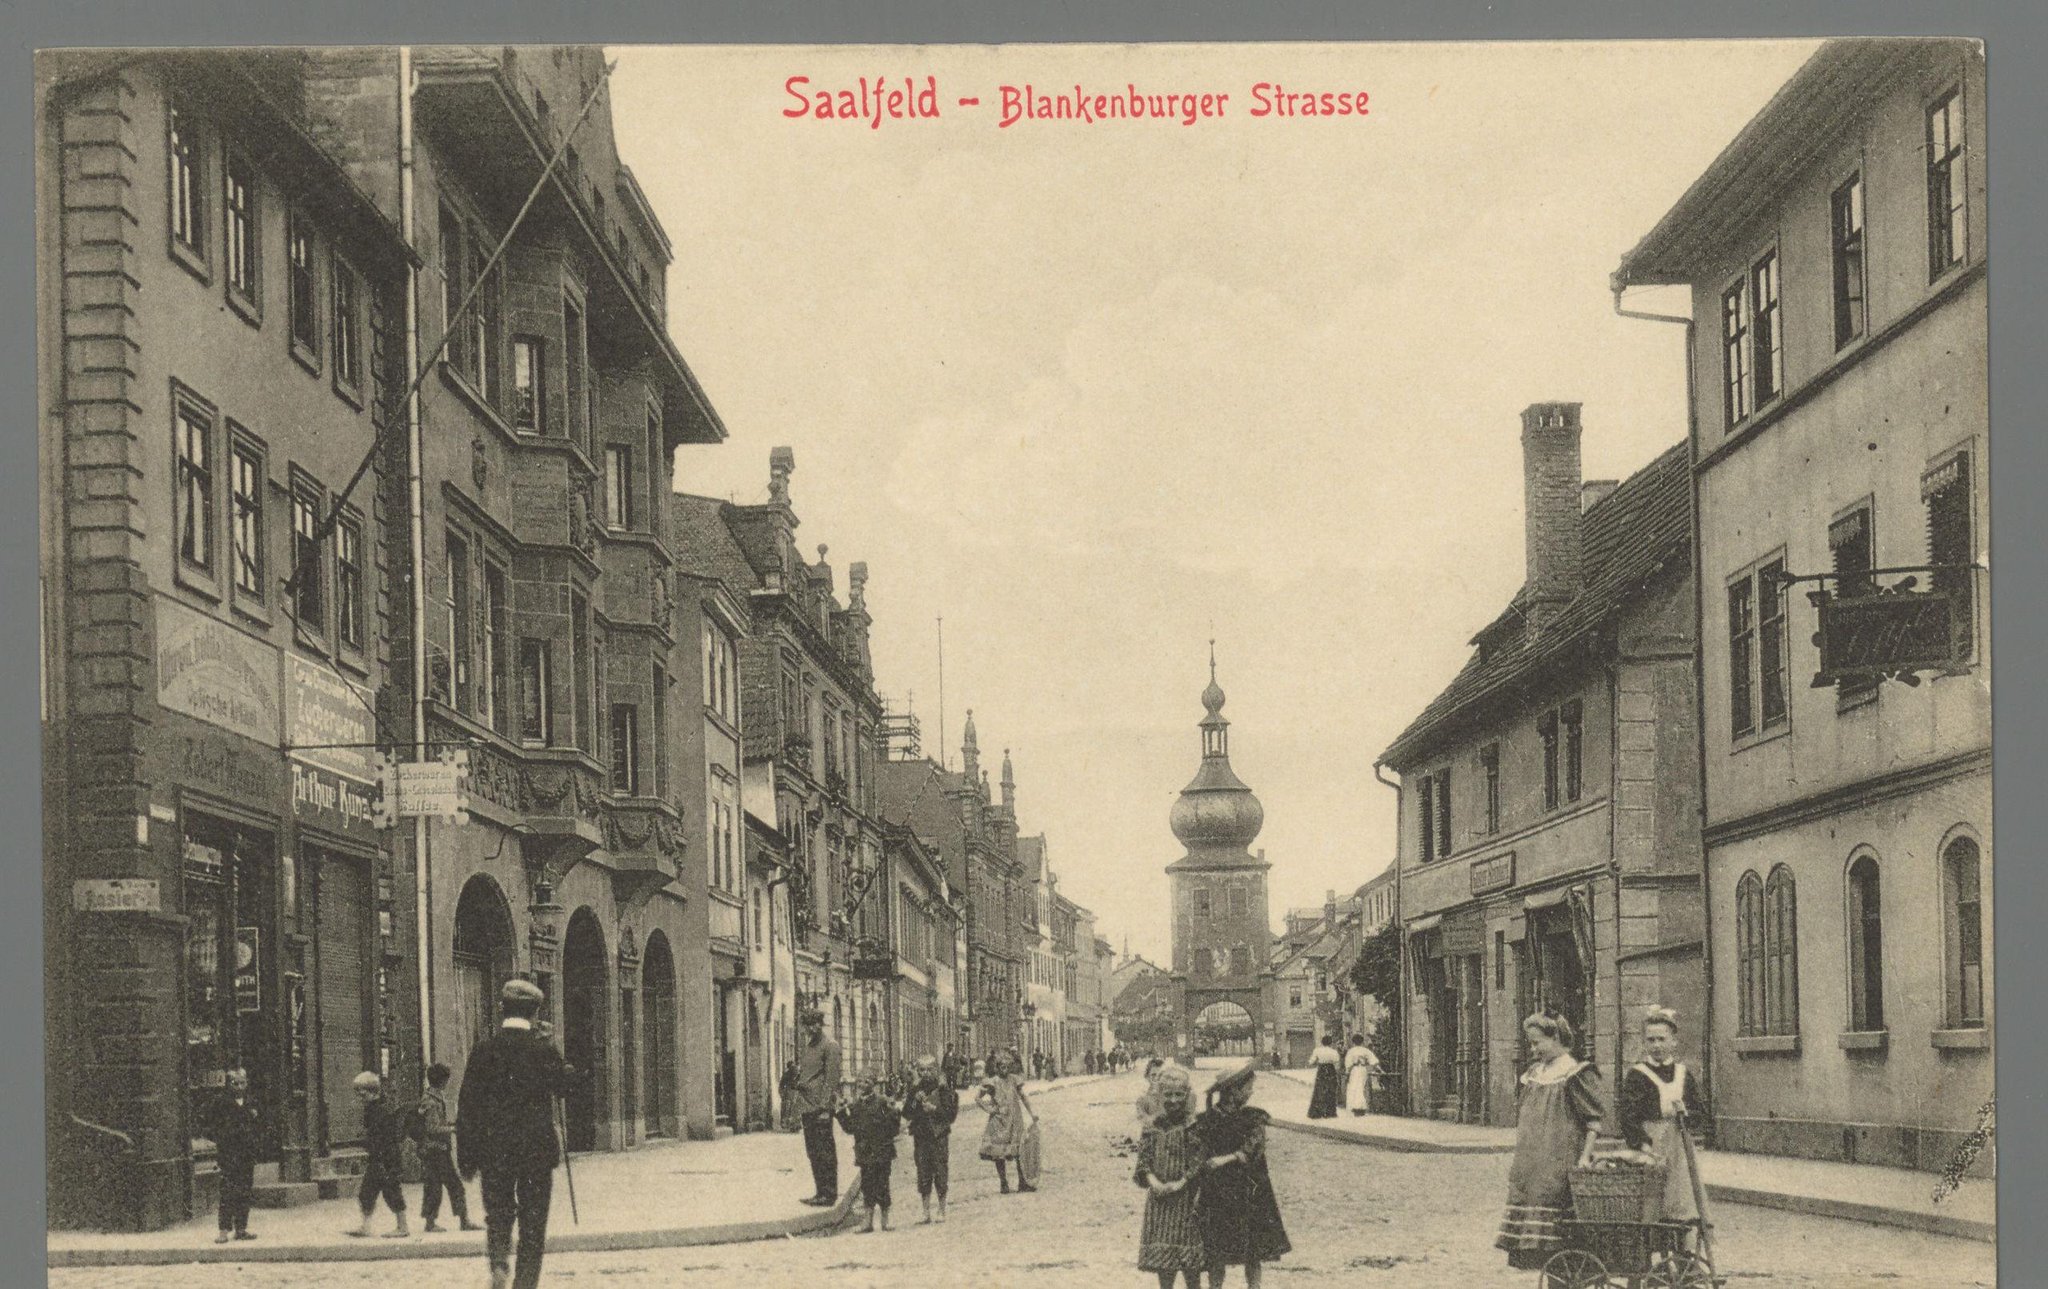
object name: photomechanical print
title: Saalfeld - Blankenburger Strasse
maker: Anonymous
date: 1905-1909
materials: cardboard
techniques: photograph, writing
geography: saalfeld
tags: street, city-gate